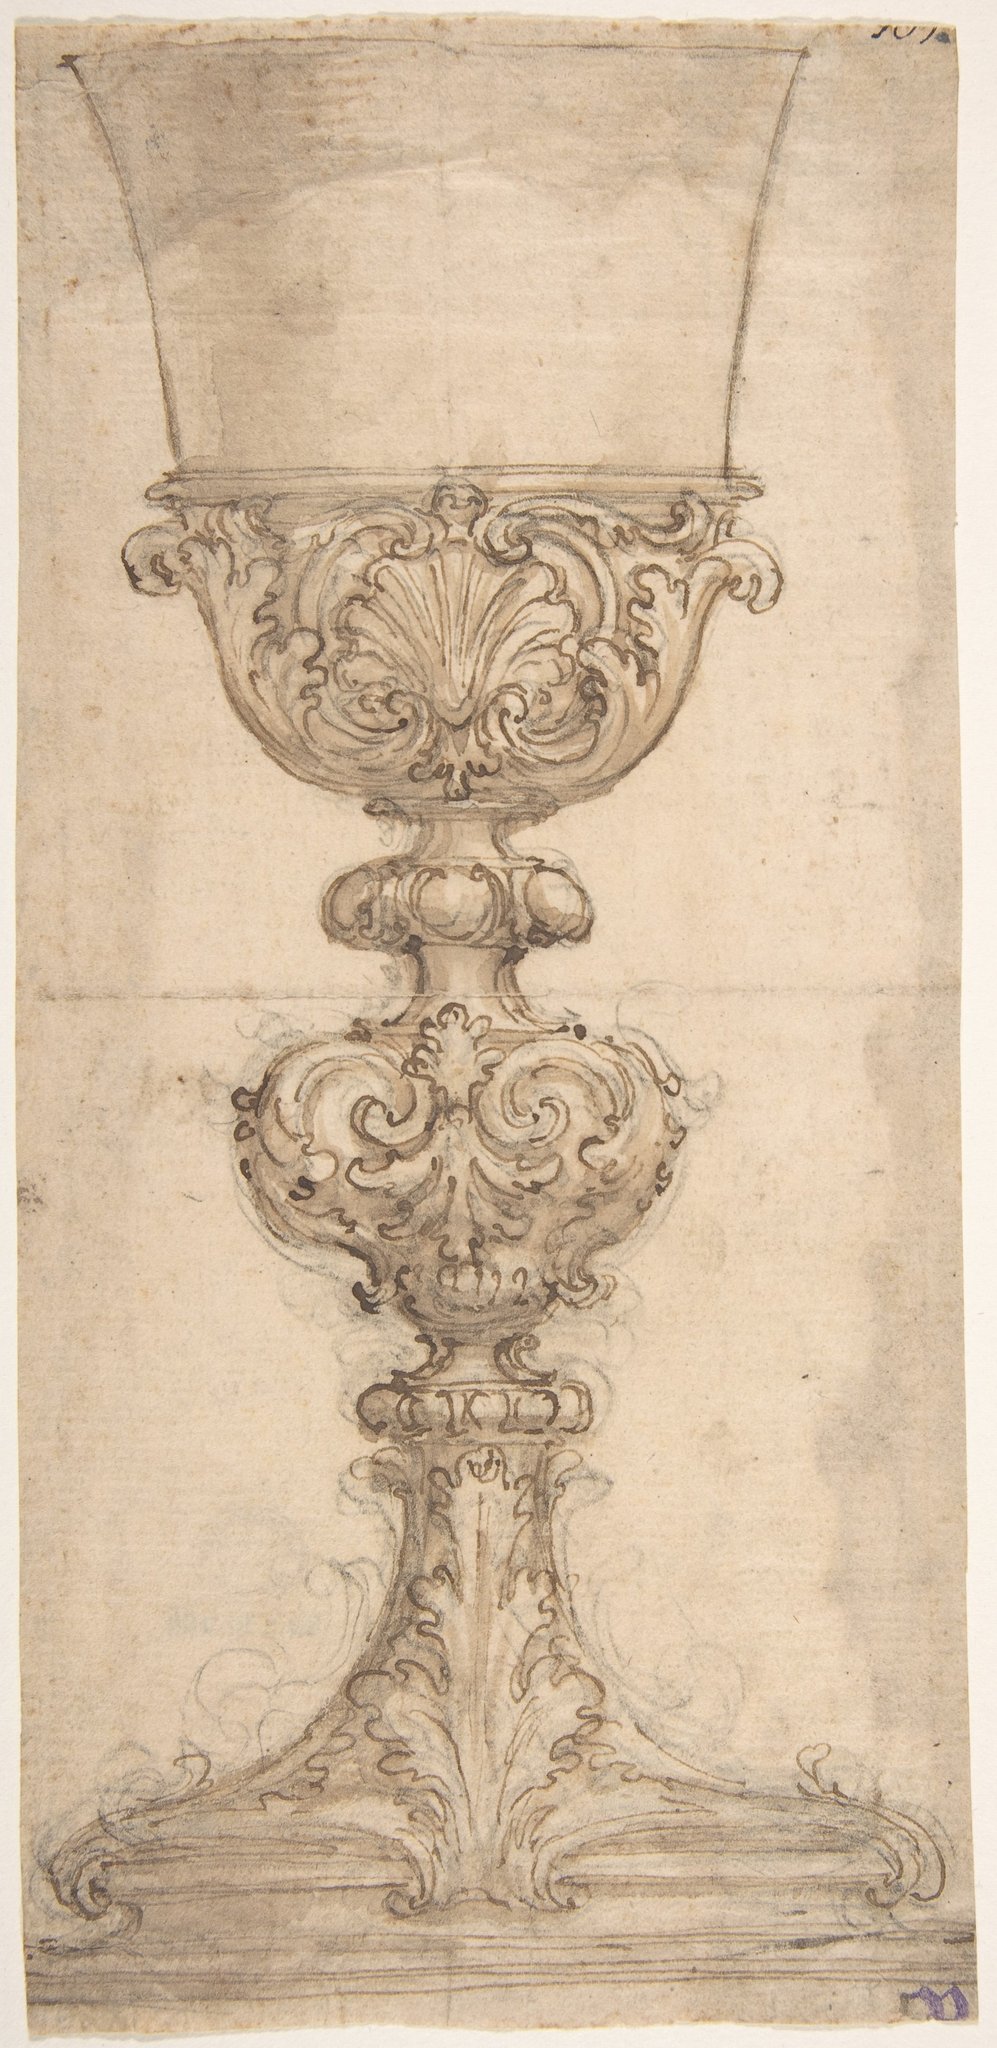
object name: drawing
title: Design for a Chalice with Acanthus and Shell Decoration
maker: giovanni battista foggini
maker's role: artist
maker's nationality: italian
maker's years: 1652-1725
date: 1672-1725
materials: chalk, ink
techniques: brush, pen, wash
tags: chalices